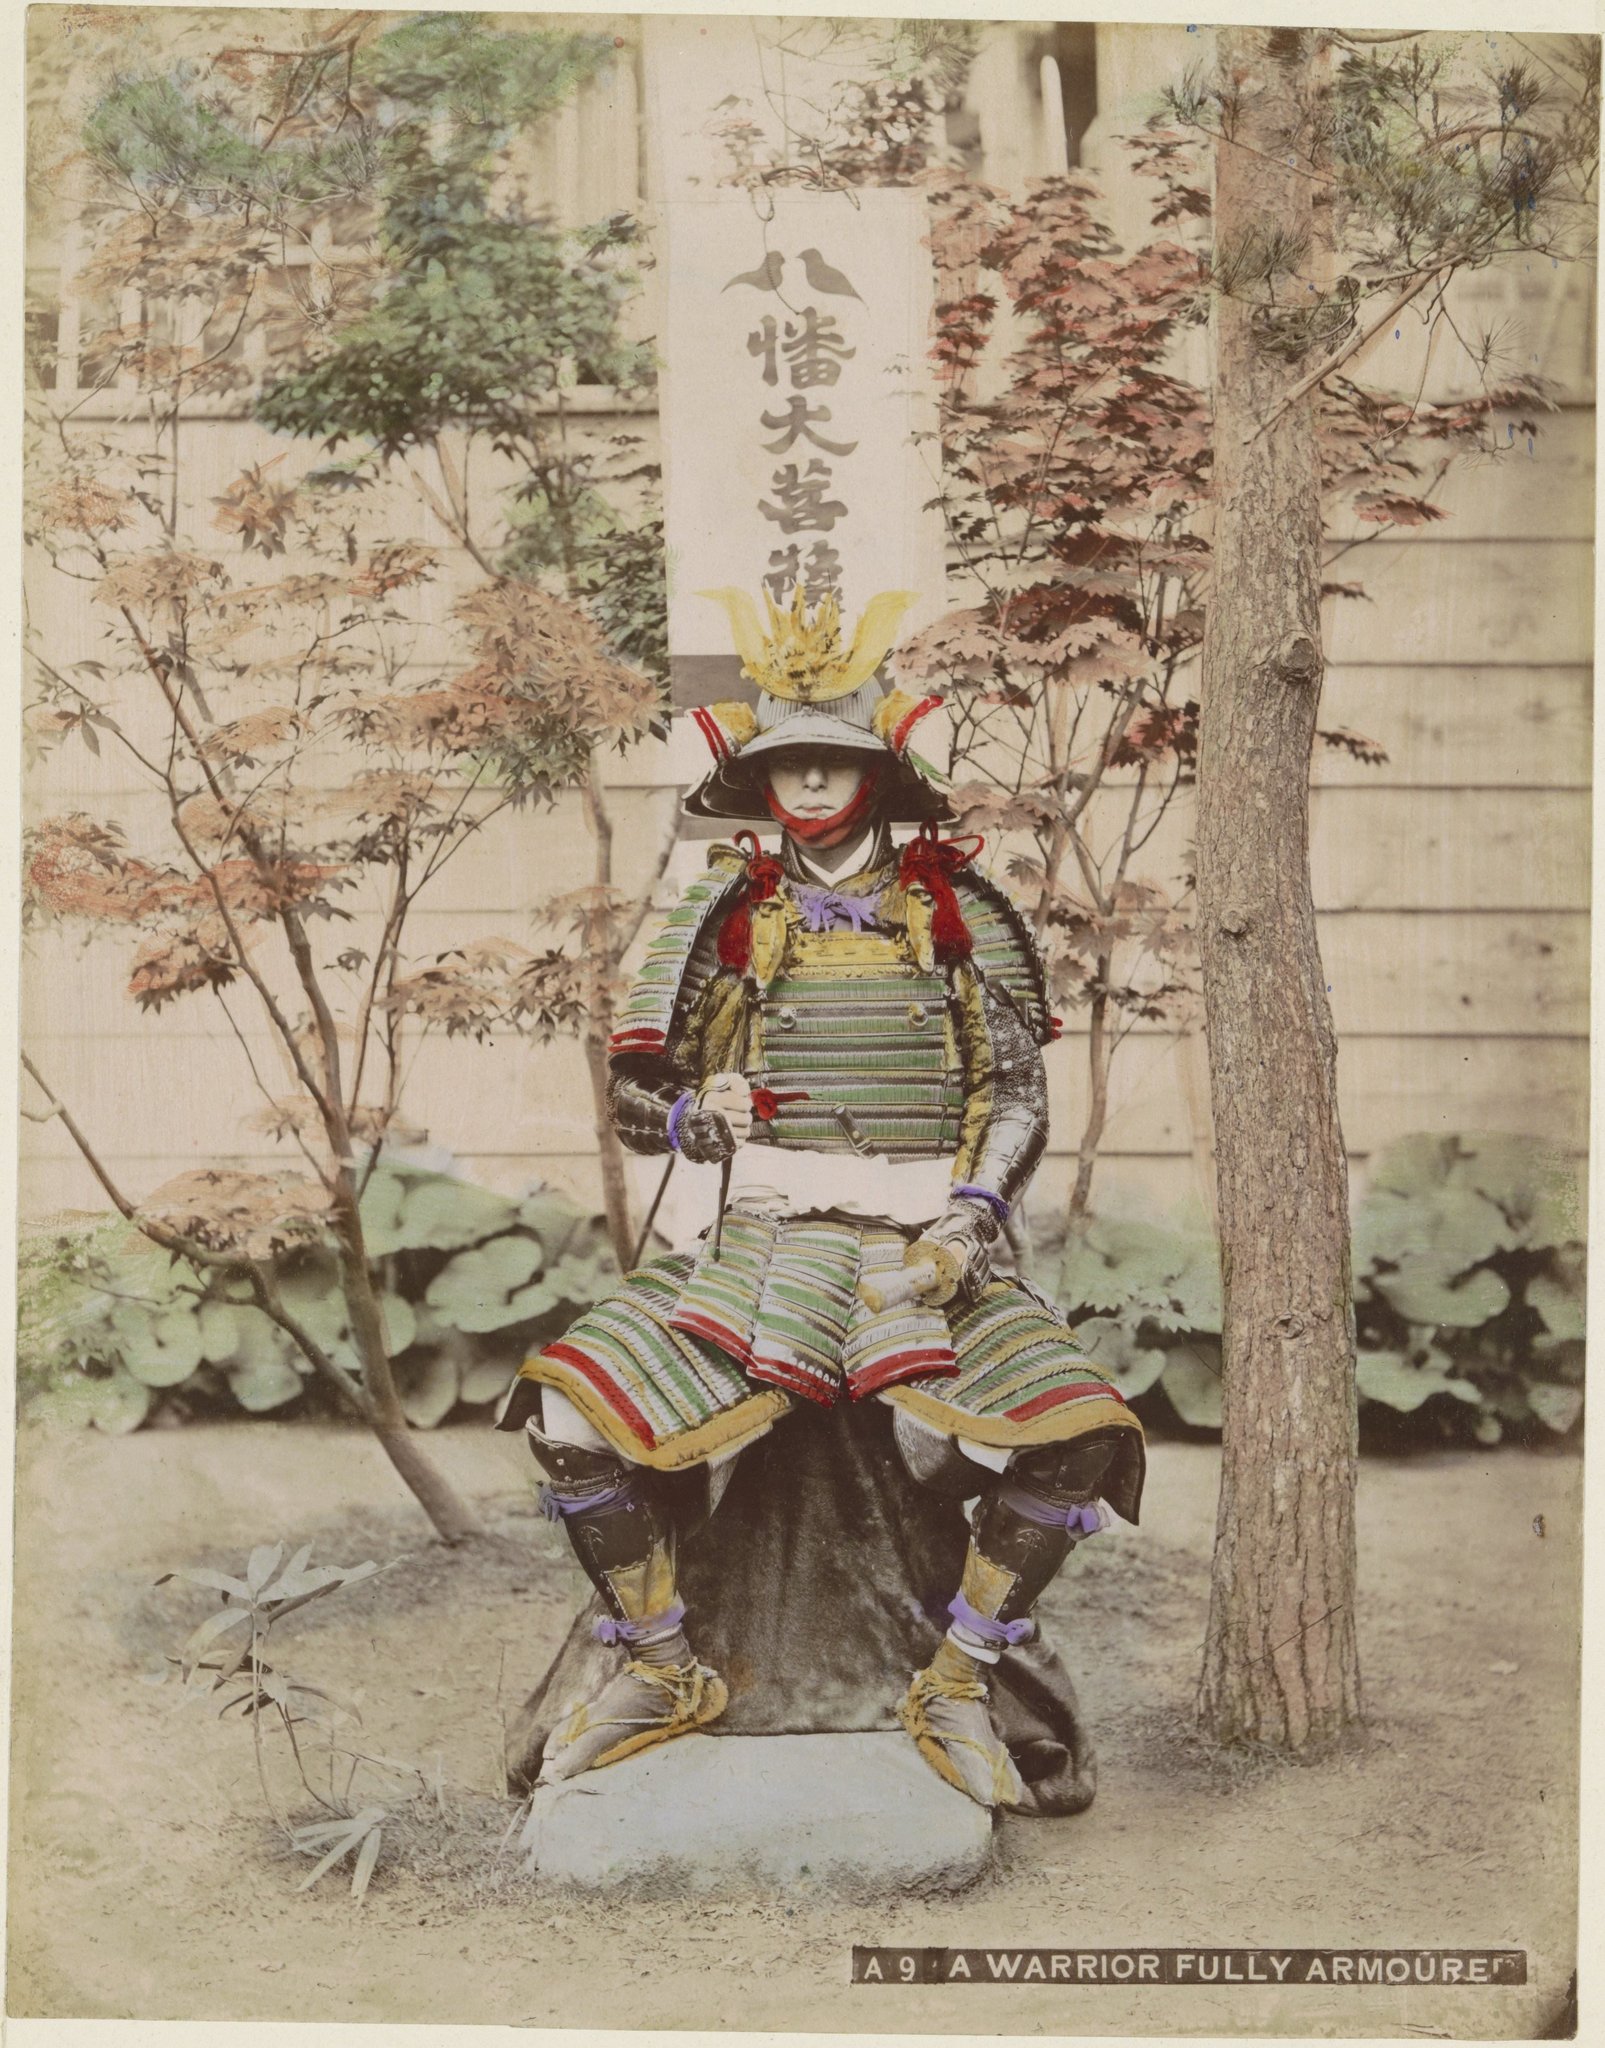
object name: photograph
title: Japanse krijger in harnas, zittend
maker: Anonymous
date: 1870-1900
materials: cardboard, paper, photographic support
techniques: albumen print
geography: japan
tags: harness, land forces, japan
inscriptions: negative number: ‘A 9’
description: Onderdeel van Reisalbum met foto's van bezienswaardigheden in Japan.